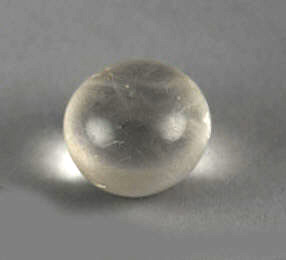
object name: rock crystal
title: Rock Crystal in Spherical Shape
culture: cambodian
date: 1101-1200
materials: quartz